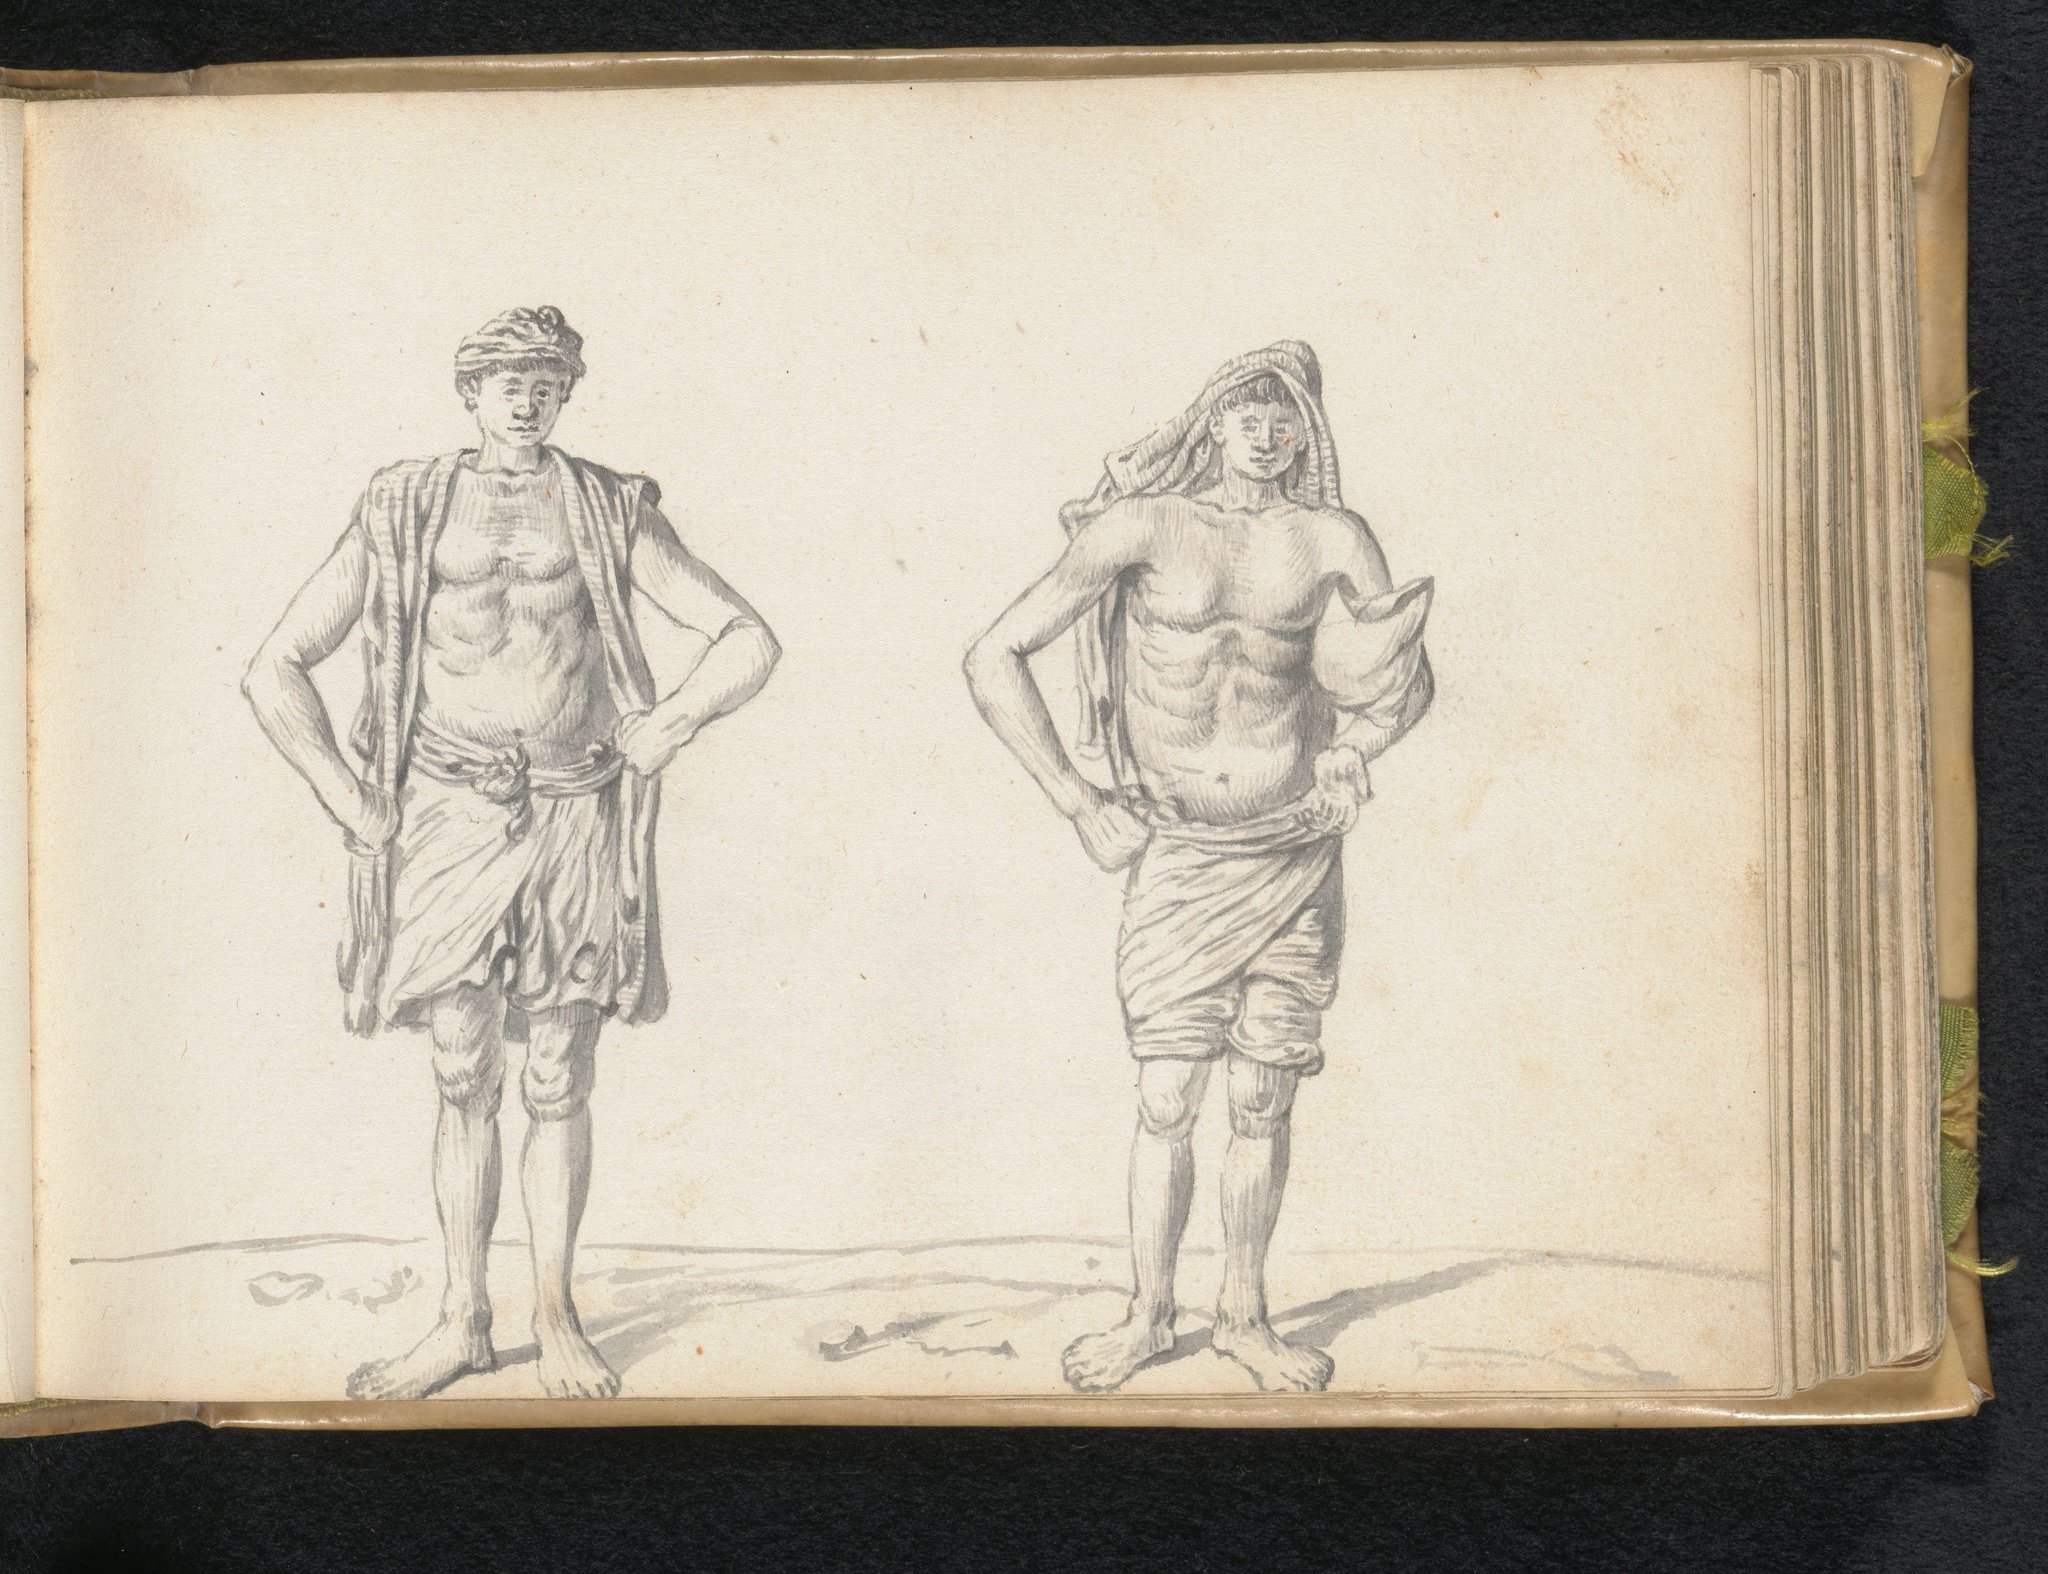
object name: sketchbook leaf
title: Two labourers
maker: esaias boursse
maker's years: 1631-1672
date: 1662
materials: ink, paper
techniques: brush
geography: sri lanka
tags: asiatic races and peoples (srilankans), skirt (dhoti), 41d232(...) skirt (lungi), head-gear (with name), asiatic races and peoples: indians, sri lanka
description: Op een oneffen terrein in de buitenlucht staan twee mannen. De man links draagt een knielang heupkleed (veshti, lungi) dubbelgeslagen omgeknoopt en in de taille vastgeknoopt. Vanaf de schouders hangen de lange uiteinden van een omgeslagen doek (chadar) van geruite stof naar beneden. Een doek is om het hoofd geknoopt; het korte haar is nog zichtbaar. De man rechts draagt ook een heupkleed (veshti, lungi) tot boven de knieën, omgewikkeld met een uiteinde tussen de benen door naar achter en dan ingestopt en omgevouwen in de taille (als een dhoti). Om het hoofd met kort haar is een losse geruite of gestreepte doek (chadar) geslagen, afhangend op de rug, een uiteinde geklemd onder de linkerarm. De mannen zijn afkomstig uit Zuid-India of Jaffna, en in Colombo tewerkgesteld in de wederopbouw. Blad 8 uit een schetsboek met 117 bladen.